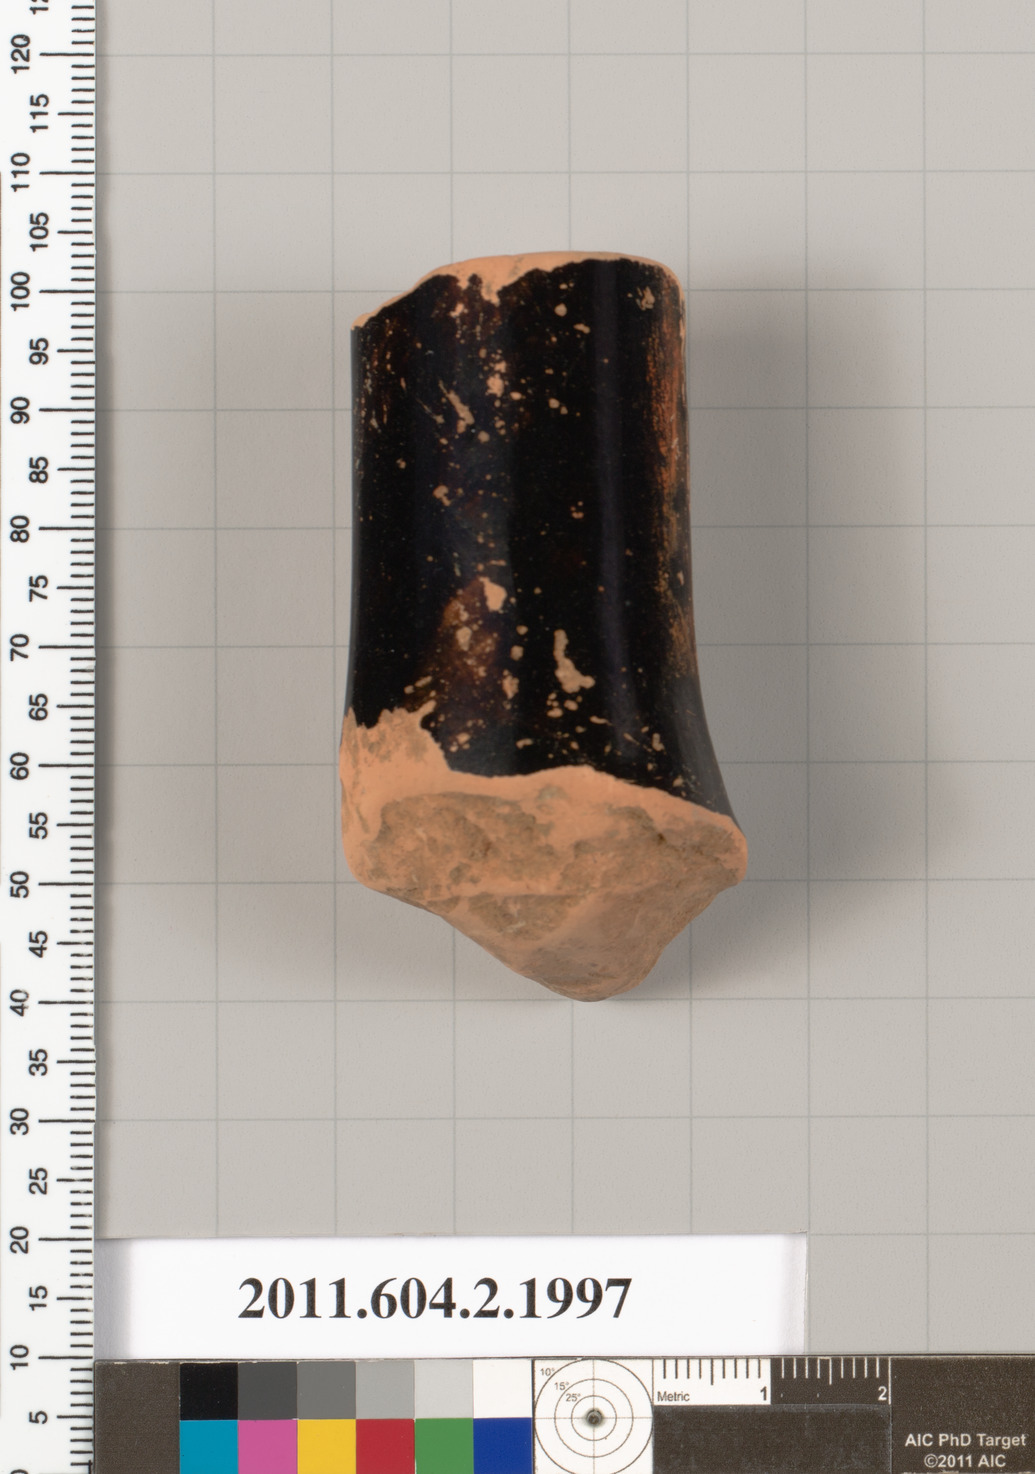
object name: krater fragment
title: Terracotta fragment of a krater (bowl for mixing wine and water)?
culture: greek, attic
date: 475-451 BCE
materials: terracotta